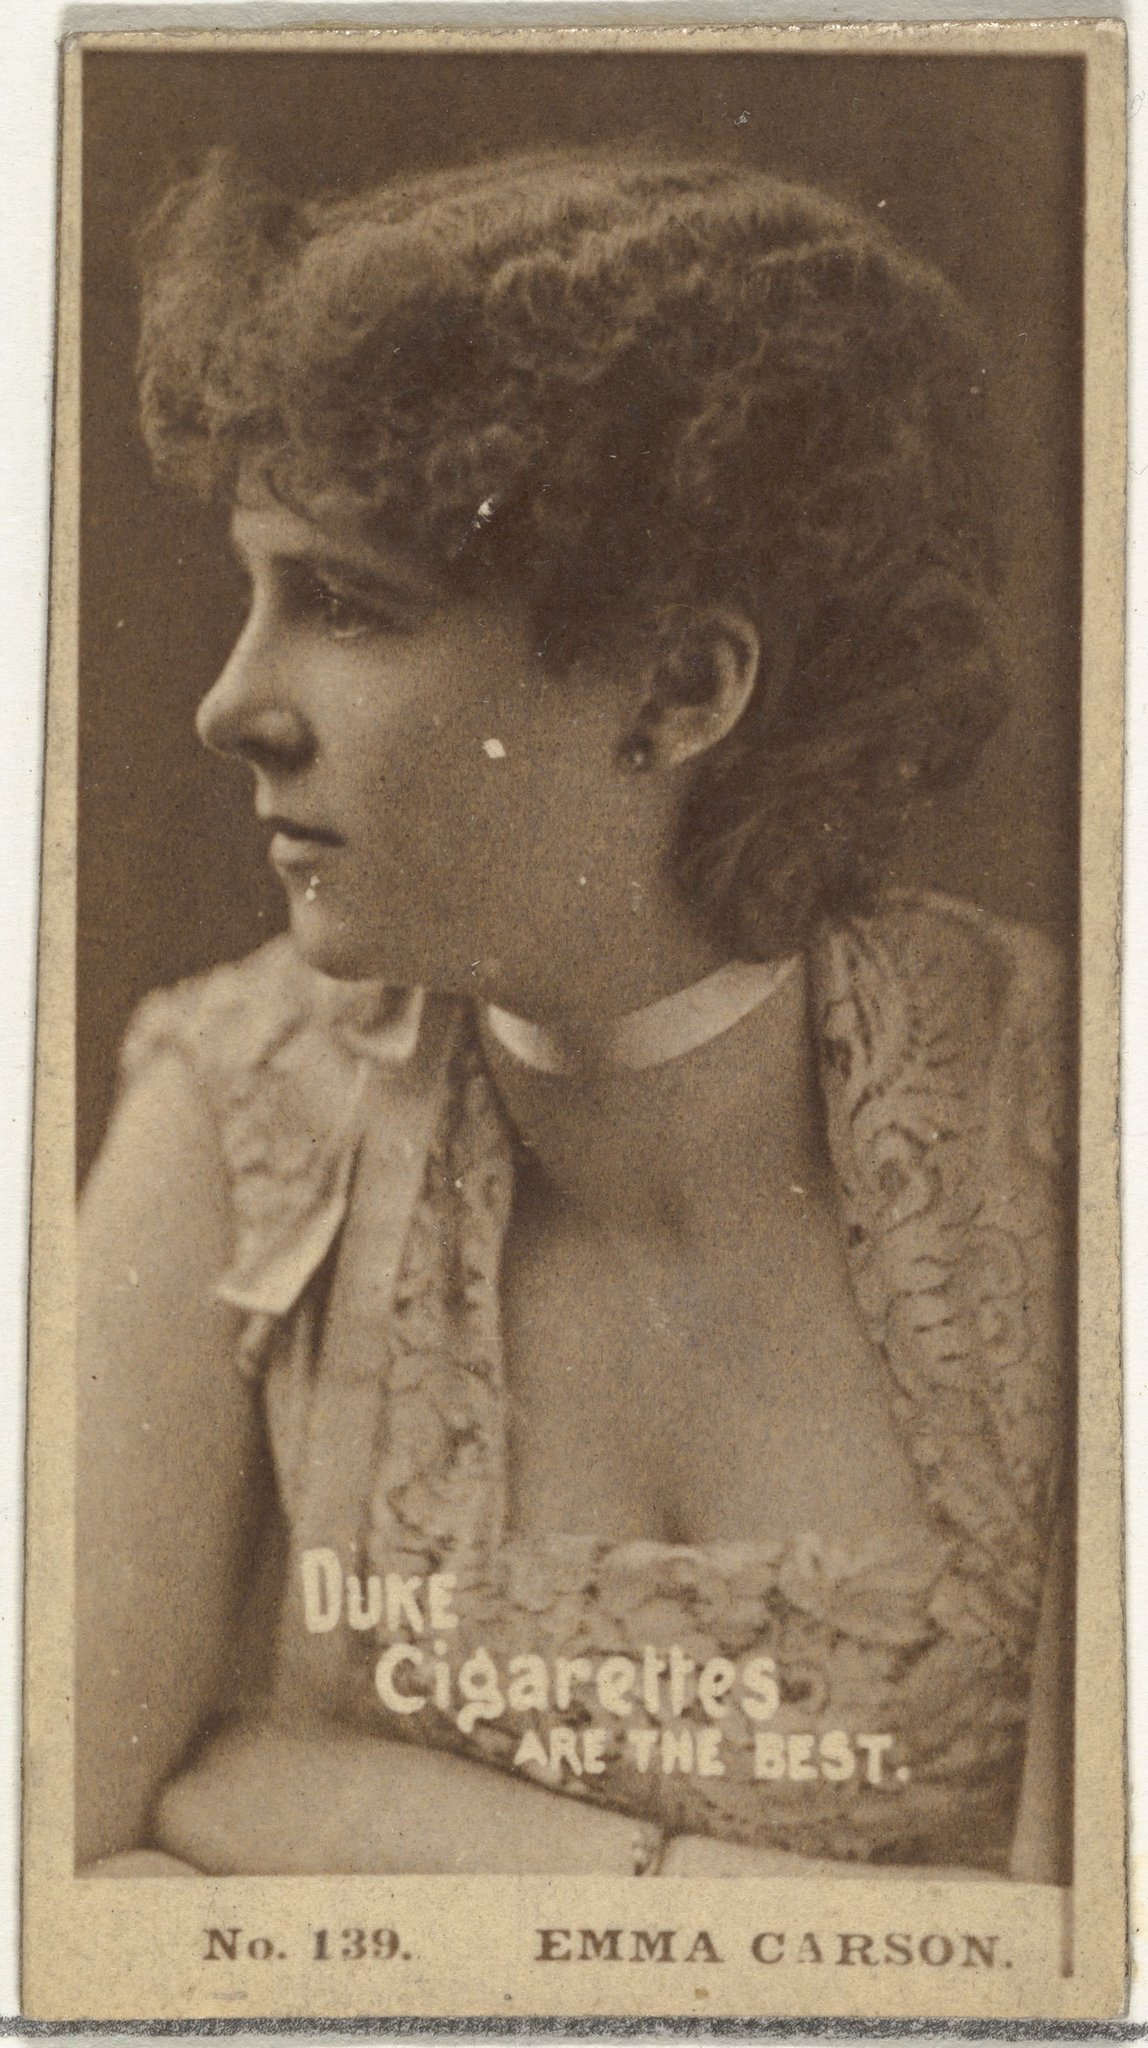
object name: photograph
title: Card Number 139, Emma Carson, from the Actors and Actresses series (N145-6) issued by Duke Sons & Co. to promote Duke Cigarettes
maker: w. duke, sons & co.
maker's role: publisher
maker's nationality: american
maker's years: 1870-1920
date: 1880-1889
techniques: albumen silver print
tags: women,actresses